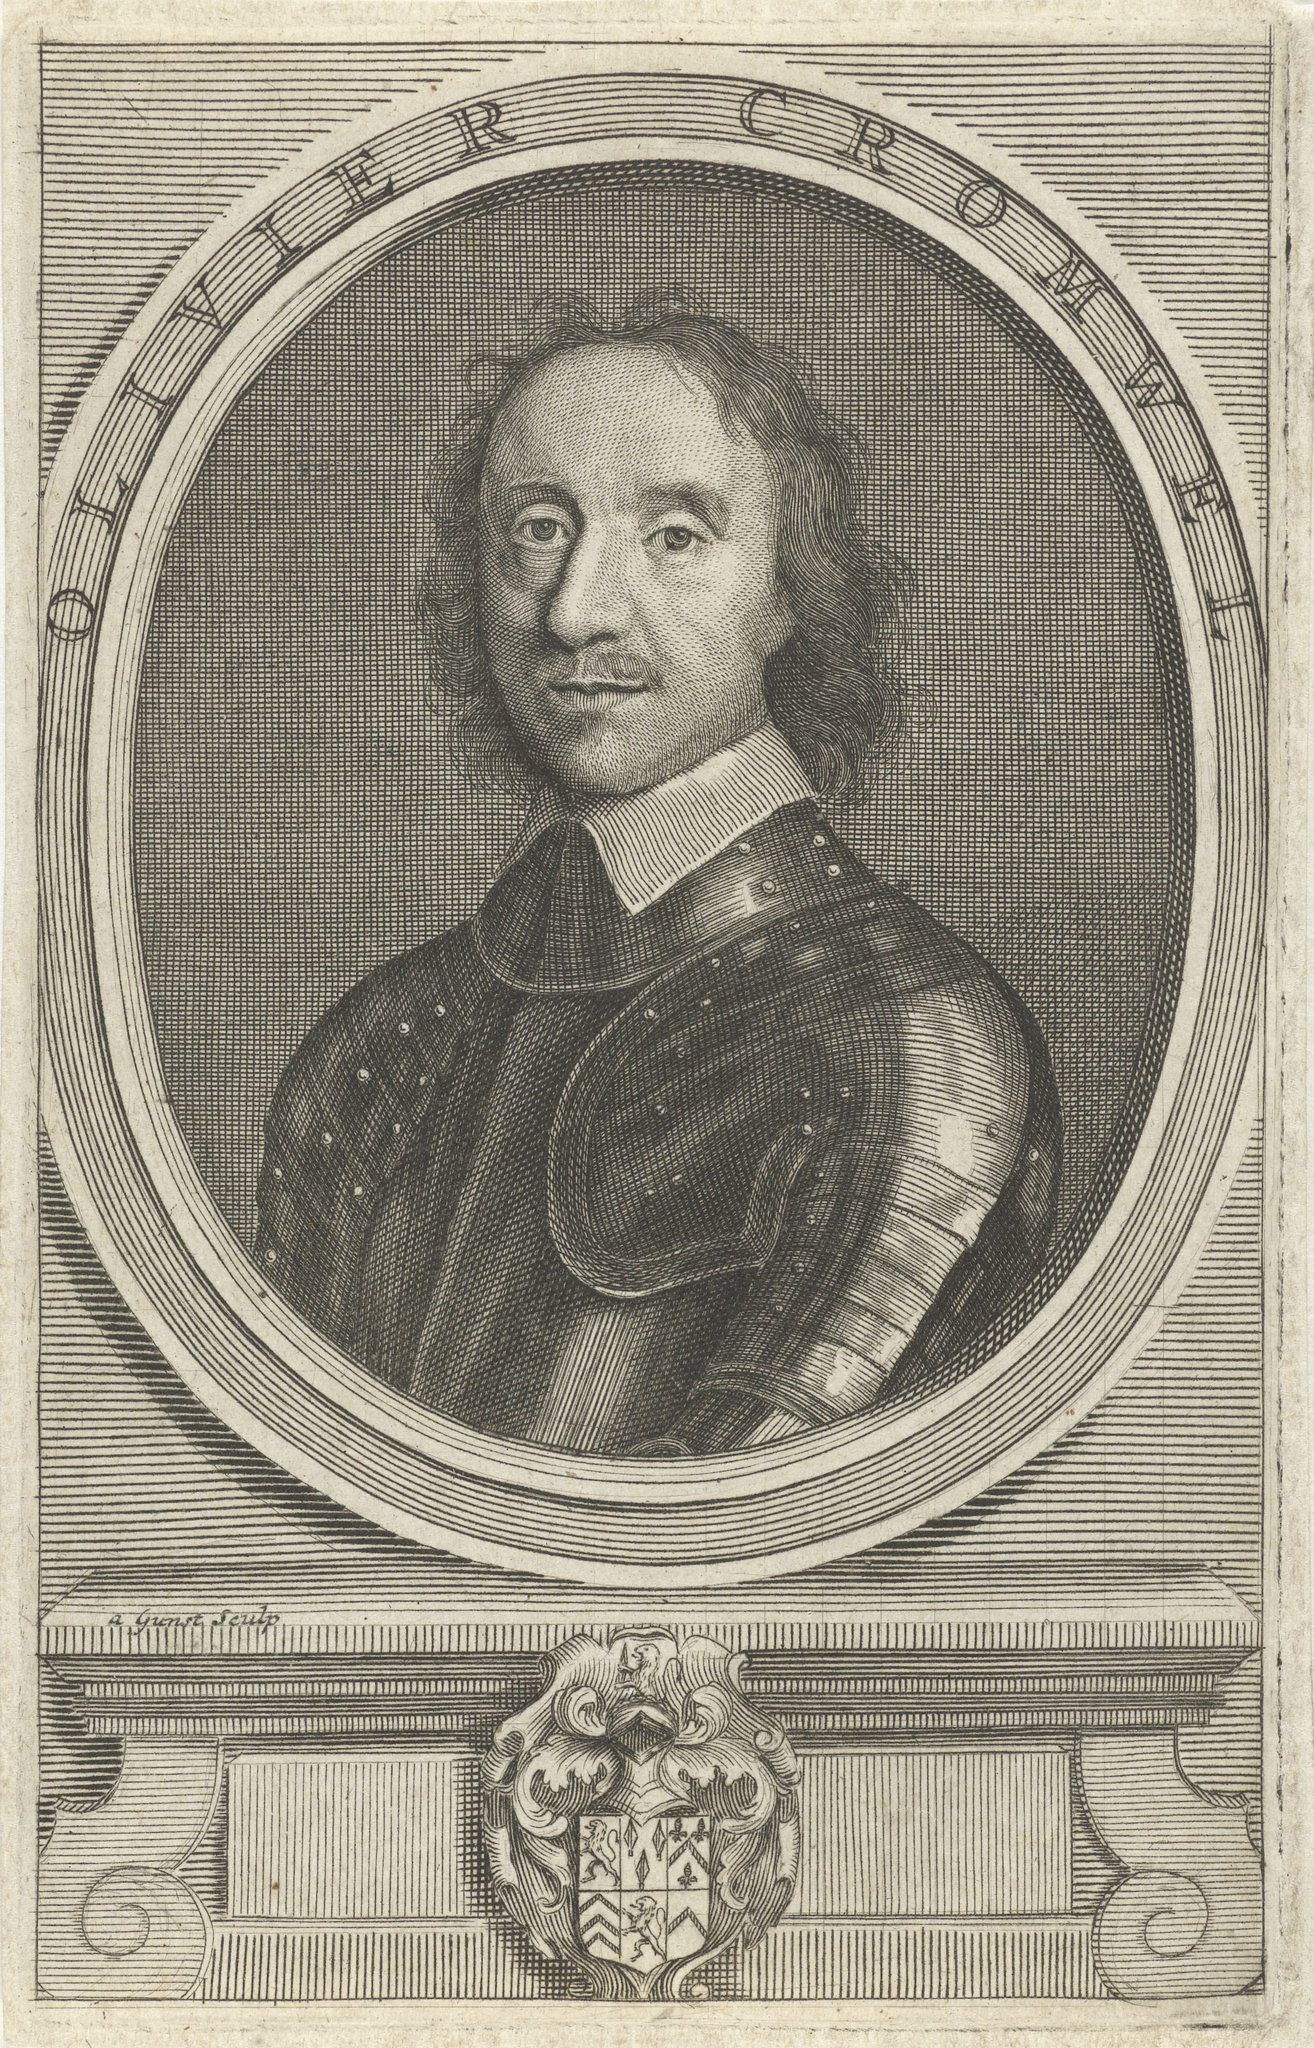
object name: print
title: Portret van Oliver Cromwell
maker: pieter van gunst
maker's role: print maker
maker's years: 1658-1731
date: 1659-1731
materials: paper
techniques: engraving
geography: amsterdam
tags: london, oliver cromwell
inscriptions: collector's mark: Lugt 2228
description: Oliver Cromwell, Lord Protector van het Verenigd Koninkrijk en Engels militair leider.